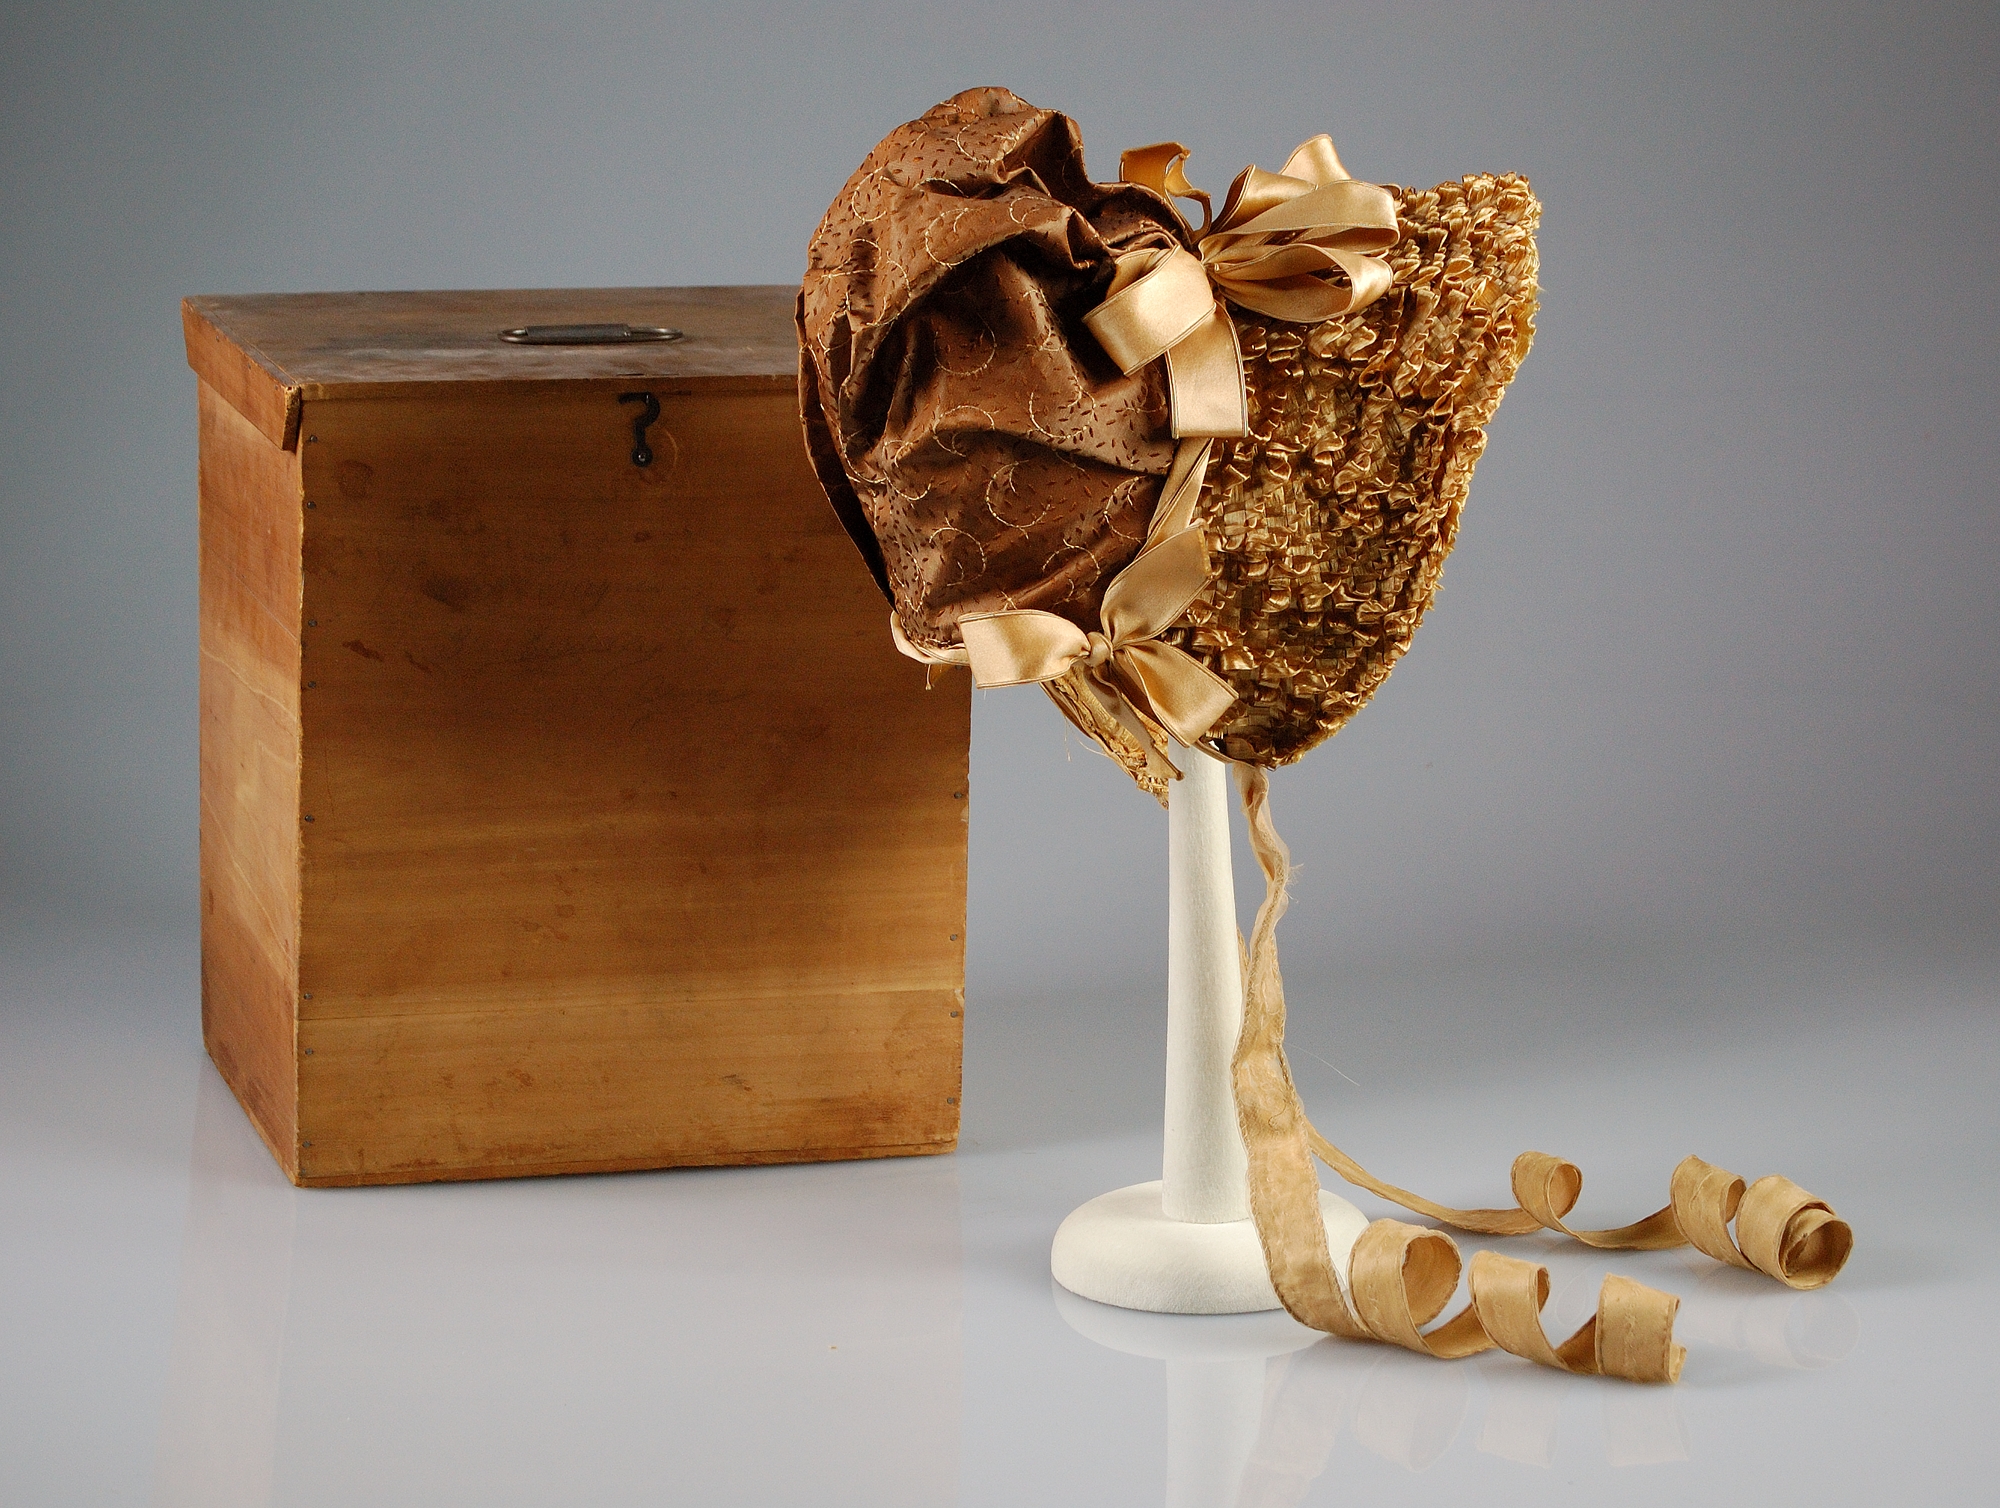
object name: bonnet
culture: french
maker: best & co.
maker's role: department store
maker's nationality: american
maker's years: 1879-1969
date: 1875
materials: metal, silk, fiber, wood